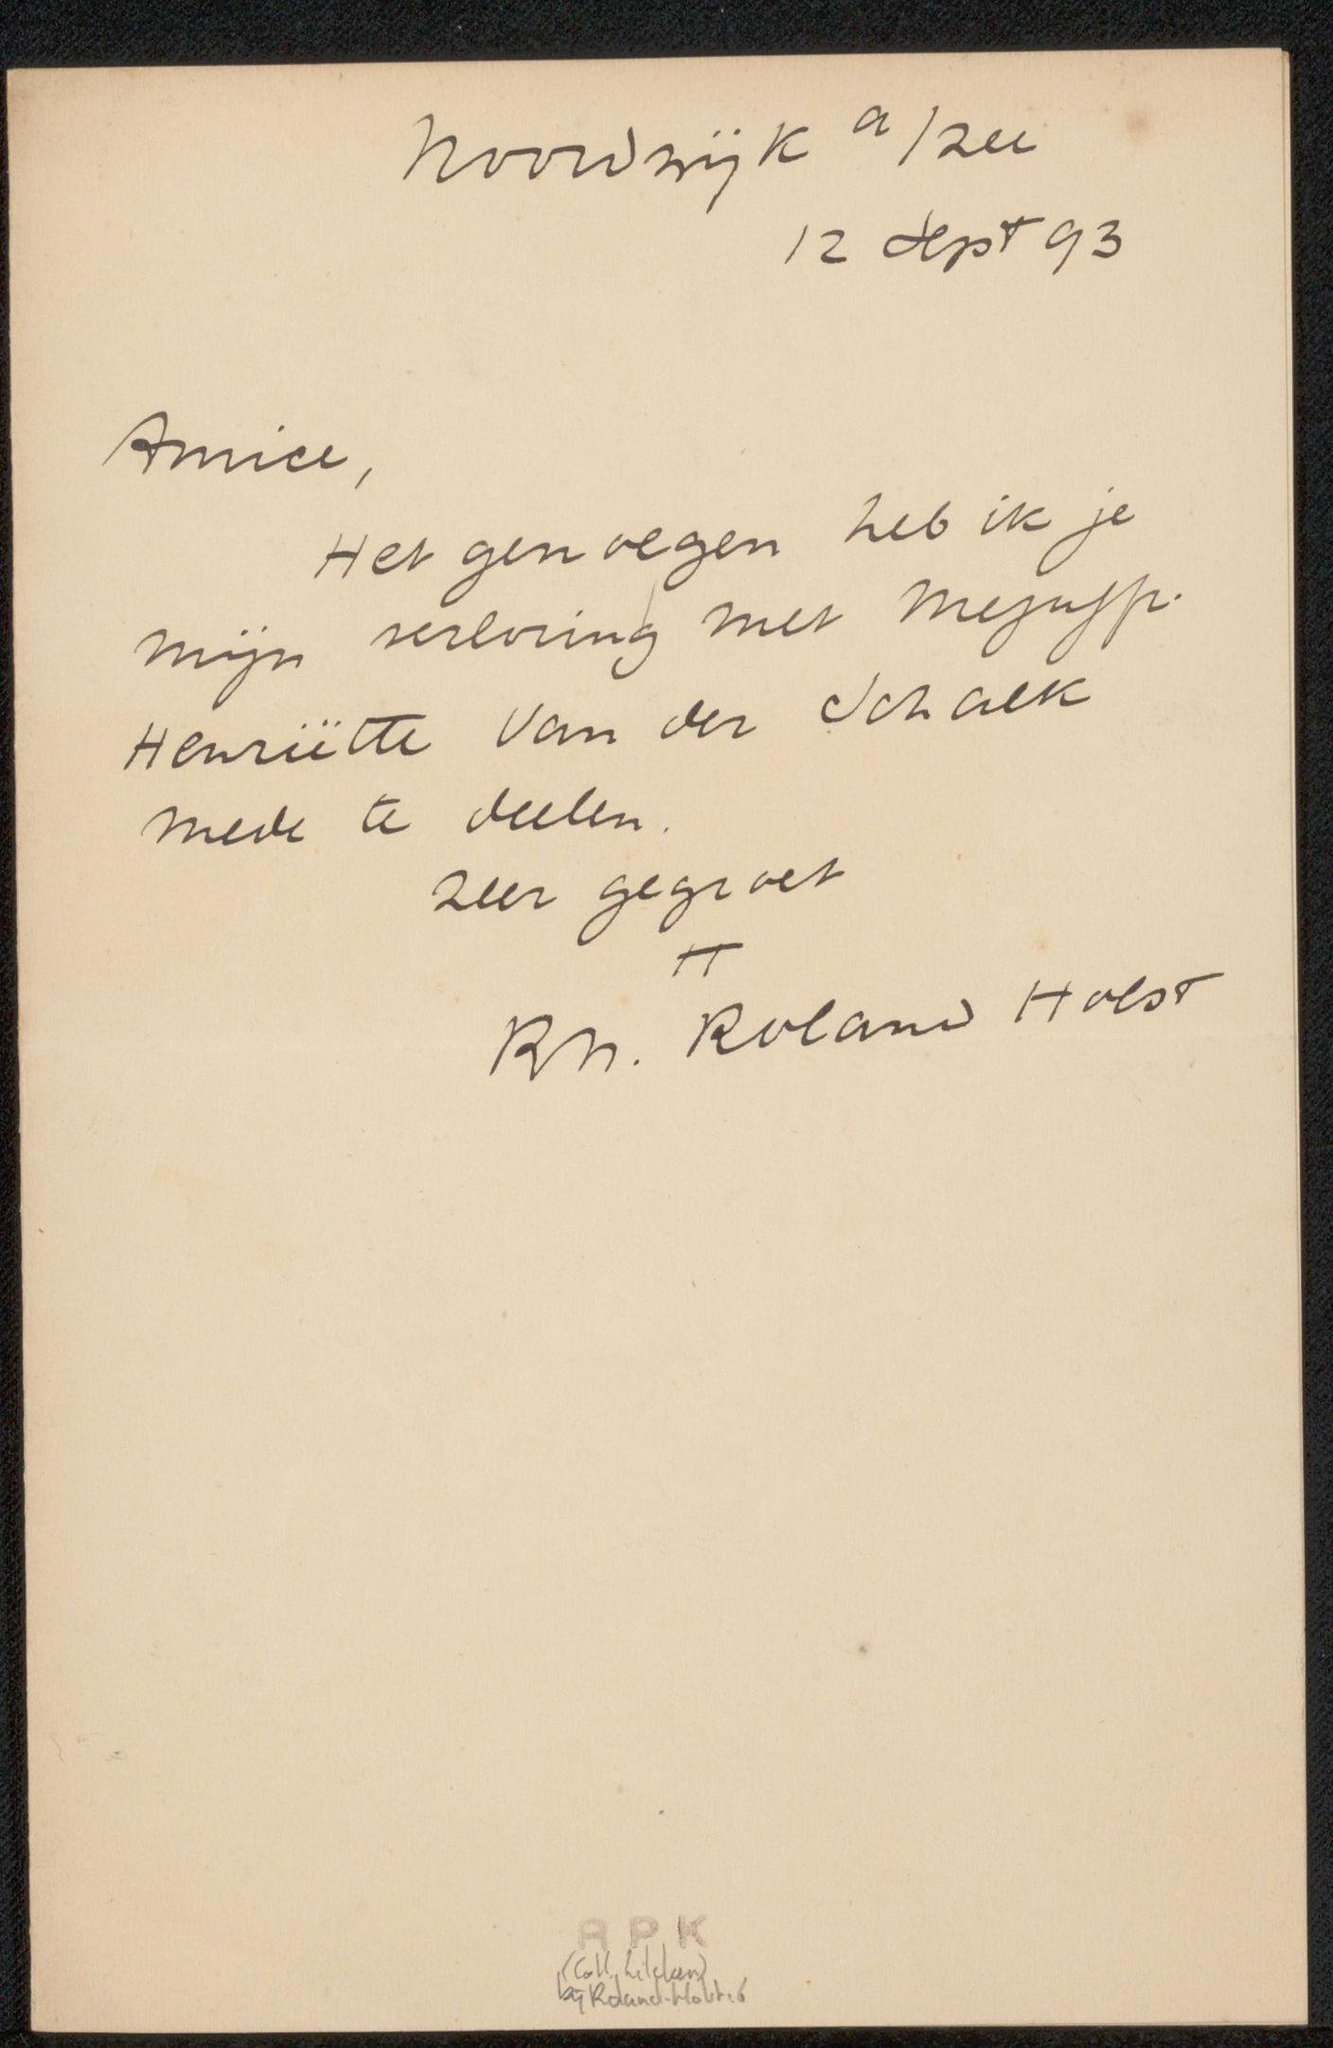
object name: letter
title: Brief aan Philip Zilcken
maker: richard nicolaüs roland holst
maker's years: 1868-1938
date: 1893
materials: ink, paper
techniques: pen, writing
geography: noordwijk aan zee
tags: amsterdam, henriëtte roland holst-van der schalk, the hague, painter, draughtsman, philip zilcken, family life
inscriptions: collector's mark: ‘RPK’, watermark